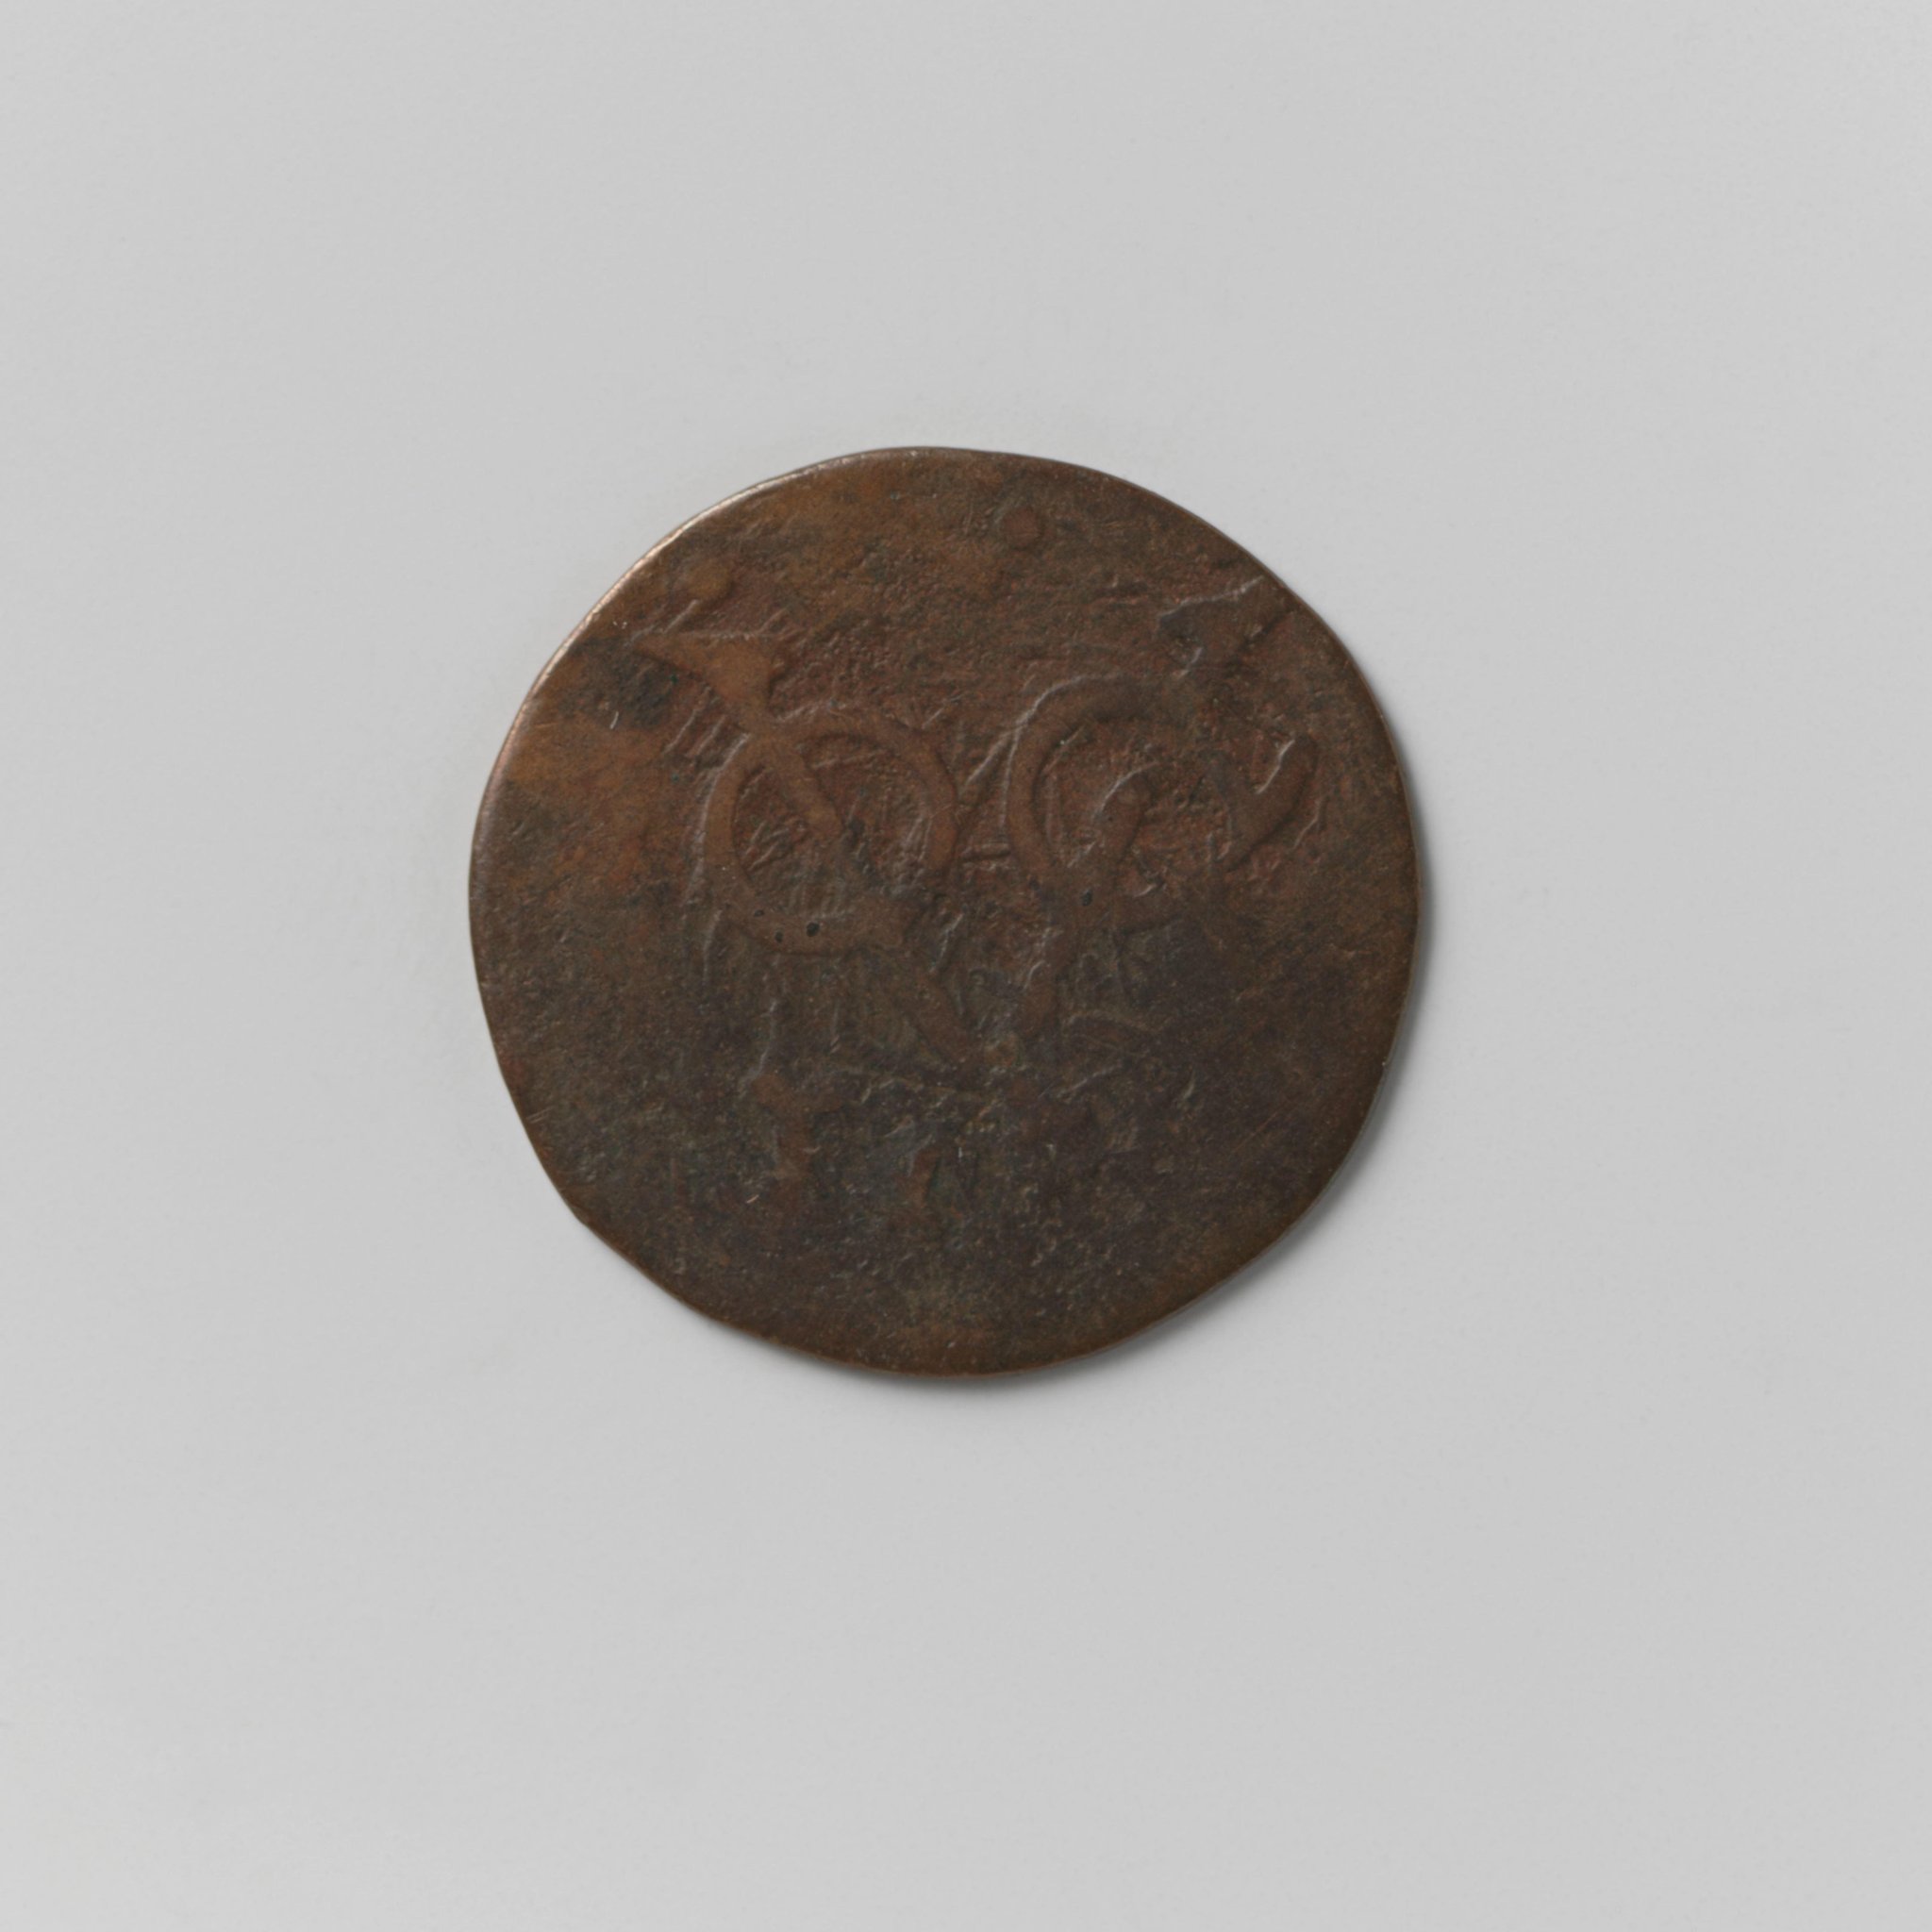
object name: coin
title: Nabootsing van VOC- duit West-Friesland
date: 1780-1830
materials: copper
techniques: striking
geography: banjarmasin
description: Koperen munt. Nabootsing van duit van de VOC uit West-Friesland. Voorzijde: gekroond wapenschild van West-Friesland. Keerzijde: monogram van de VOC, waaronder fictief jaartal.